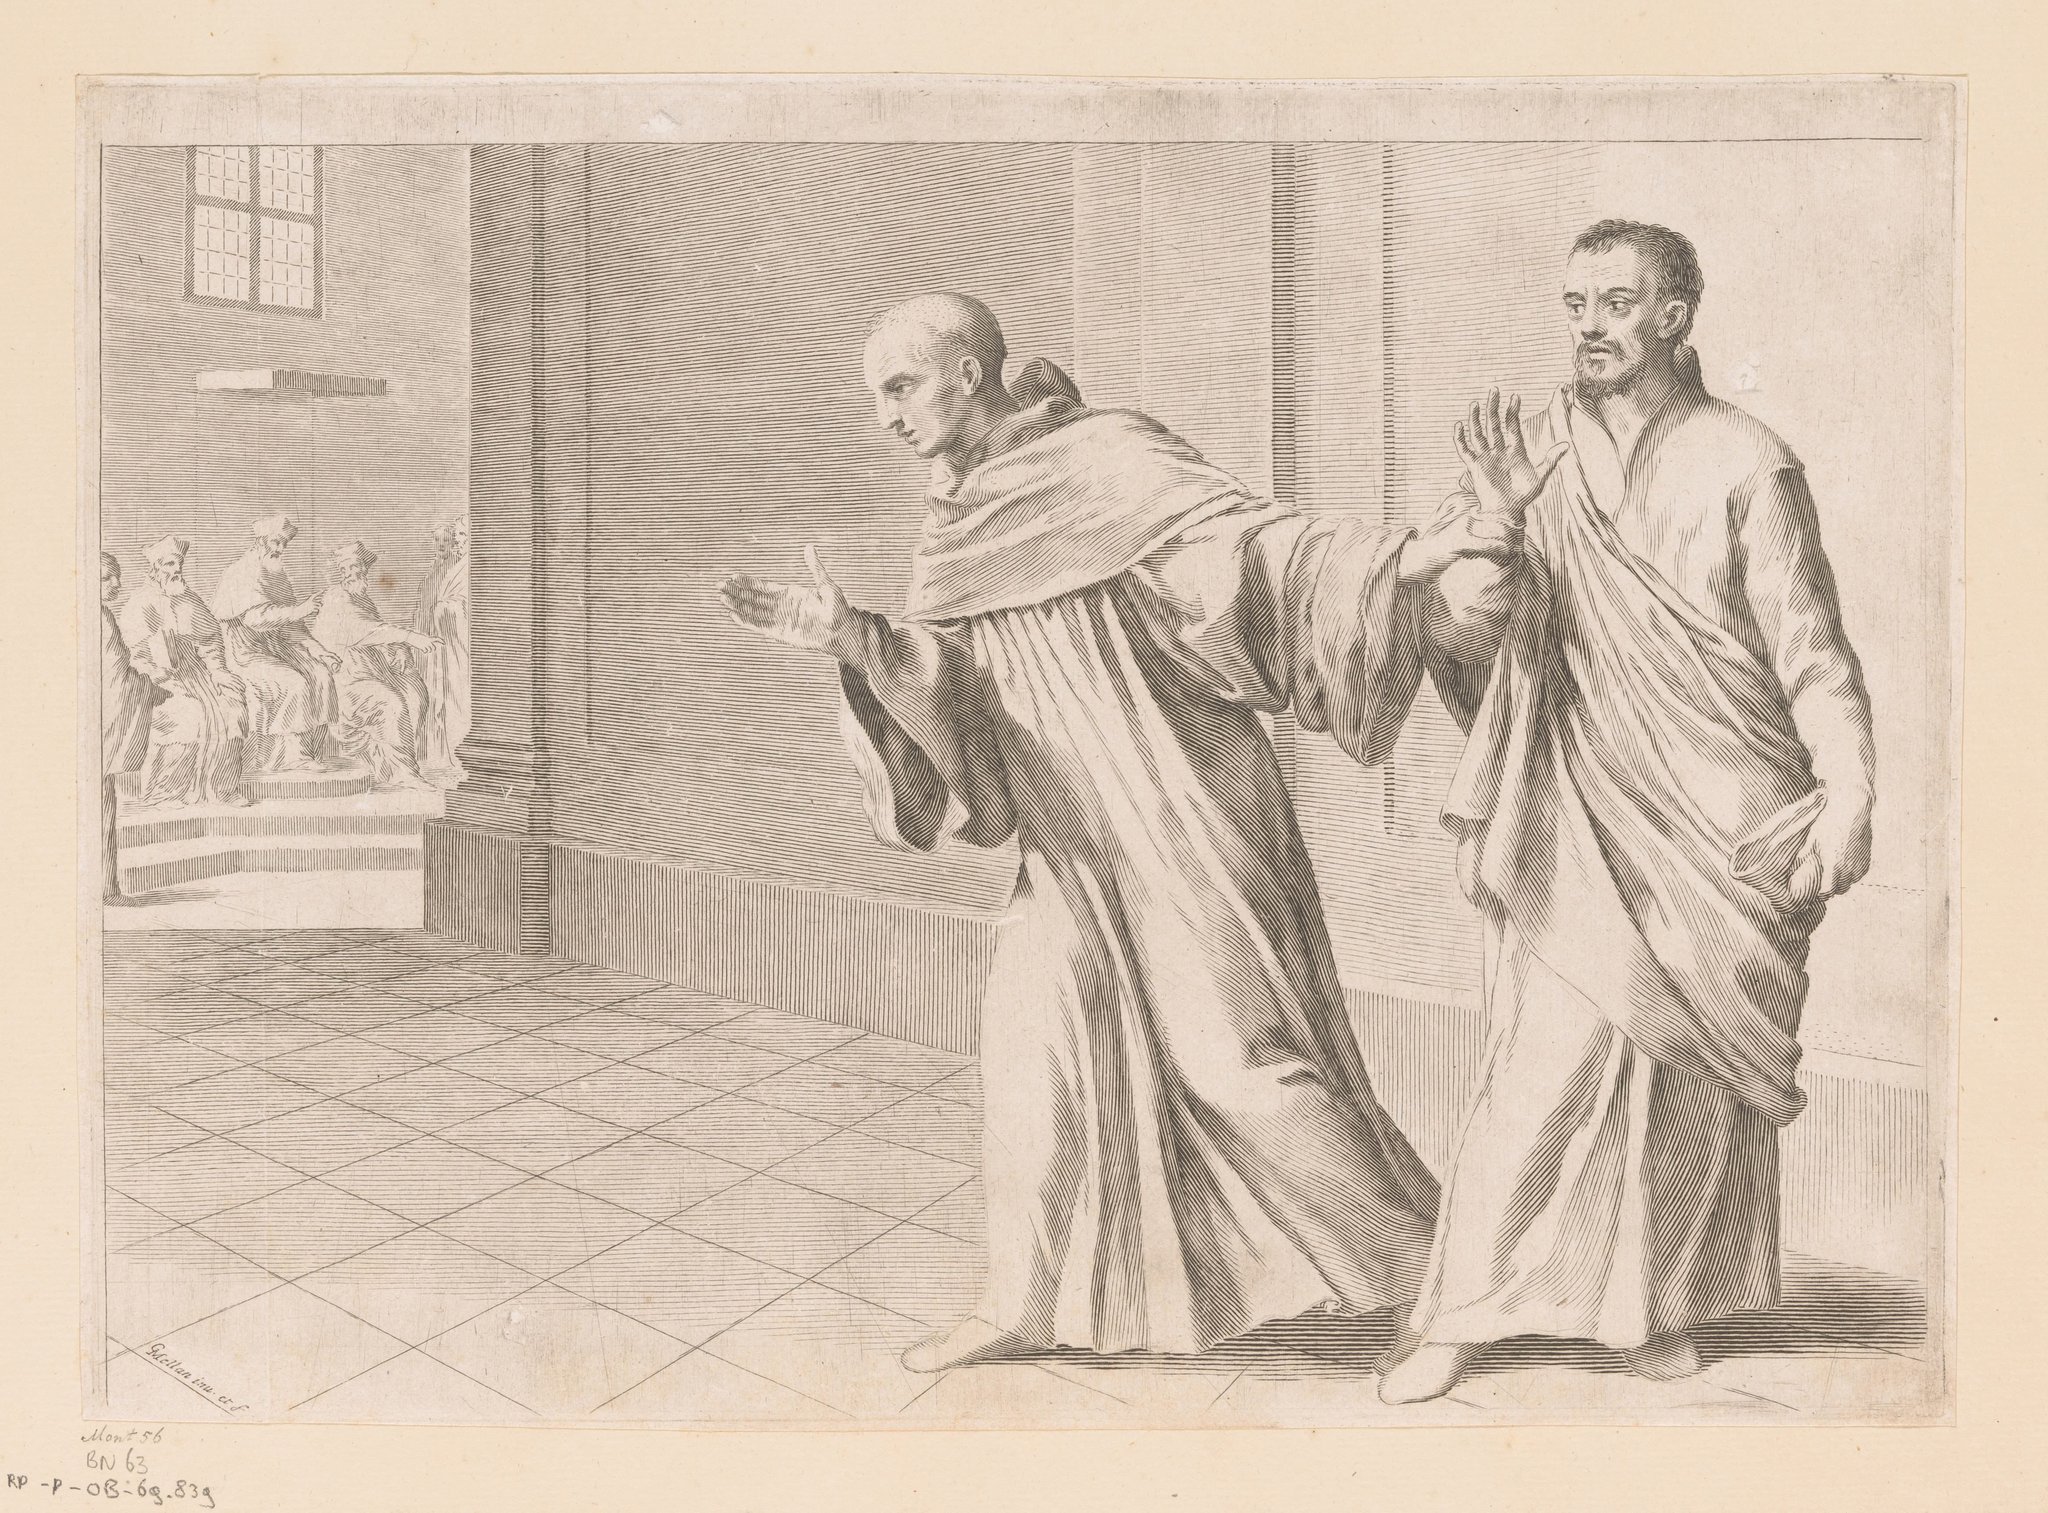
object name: print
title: H. Bernardus in discussie met Abélard tijdens het concilie van Soissons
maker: claude mellan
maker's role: draughtsman, print maker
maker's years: 1598-1688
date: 1608-1688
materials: paper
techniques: engraving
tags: bernard of clairvaux, cistercian monk and abbot; possible attributes: beehive, chained dragon, crucifix, cross with instruments of the passion, (three) mitre at his feet, white dog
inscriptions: collector's mark: Lugt 240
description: Maakt deel uit van een vierdelige serie met scènes uit het leven van Bernardus van Clairvaux.